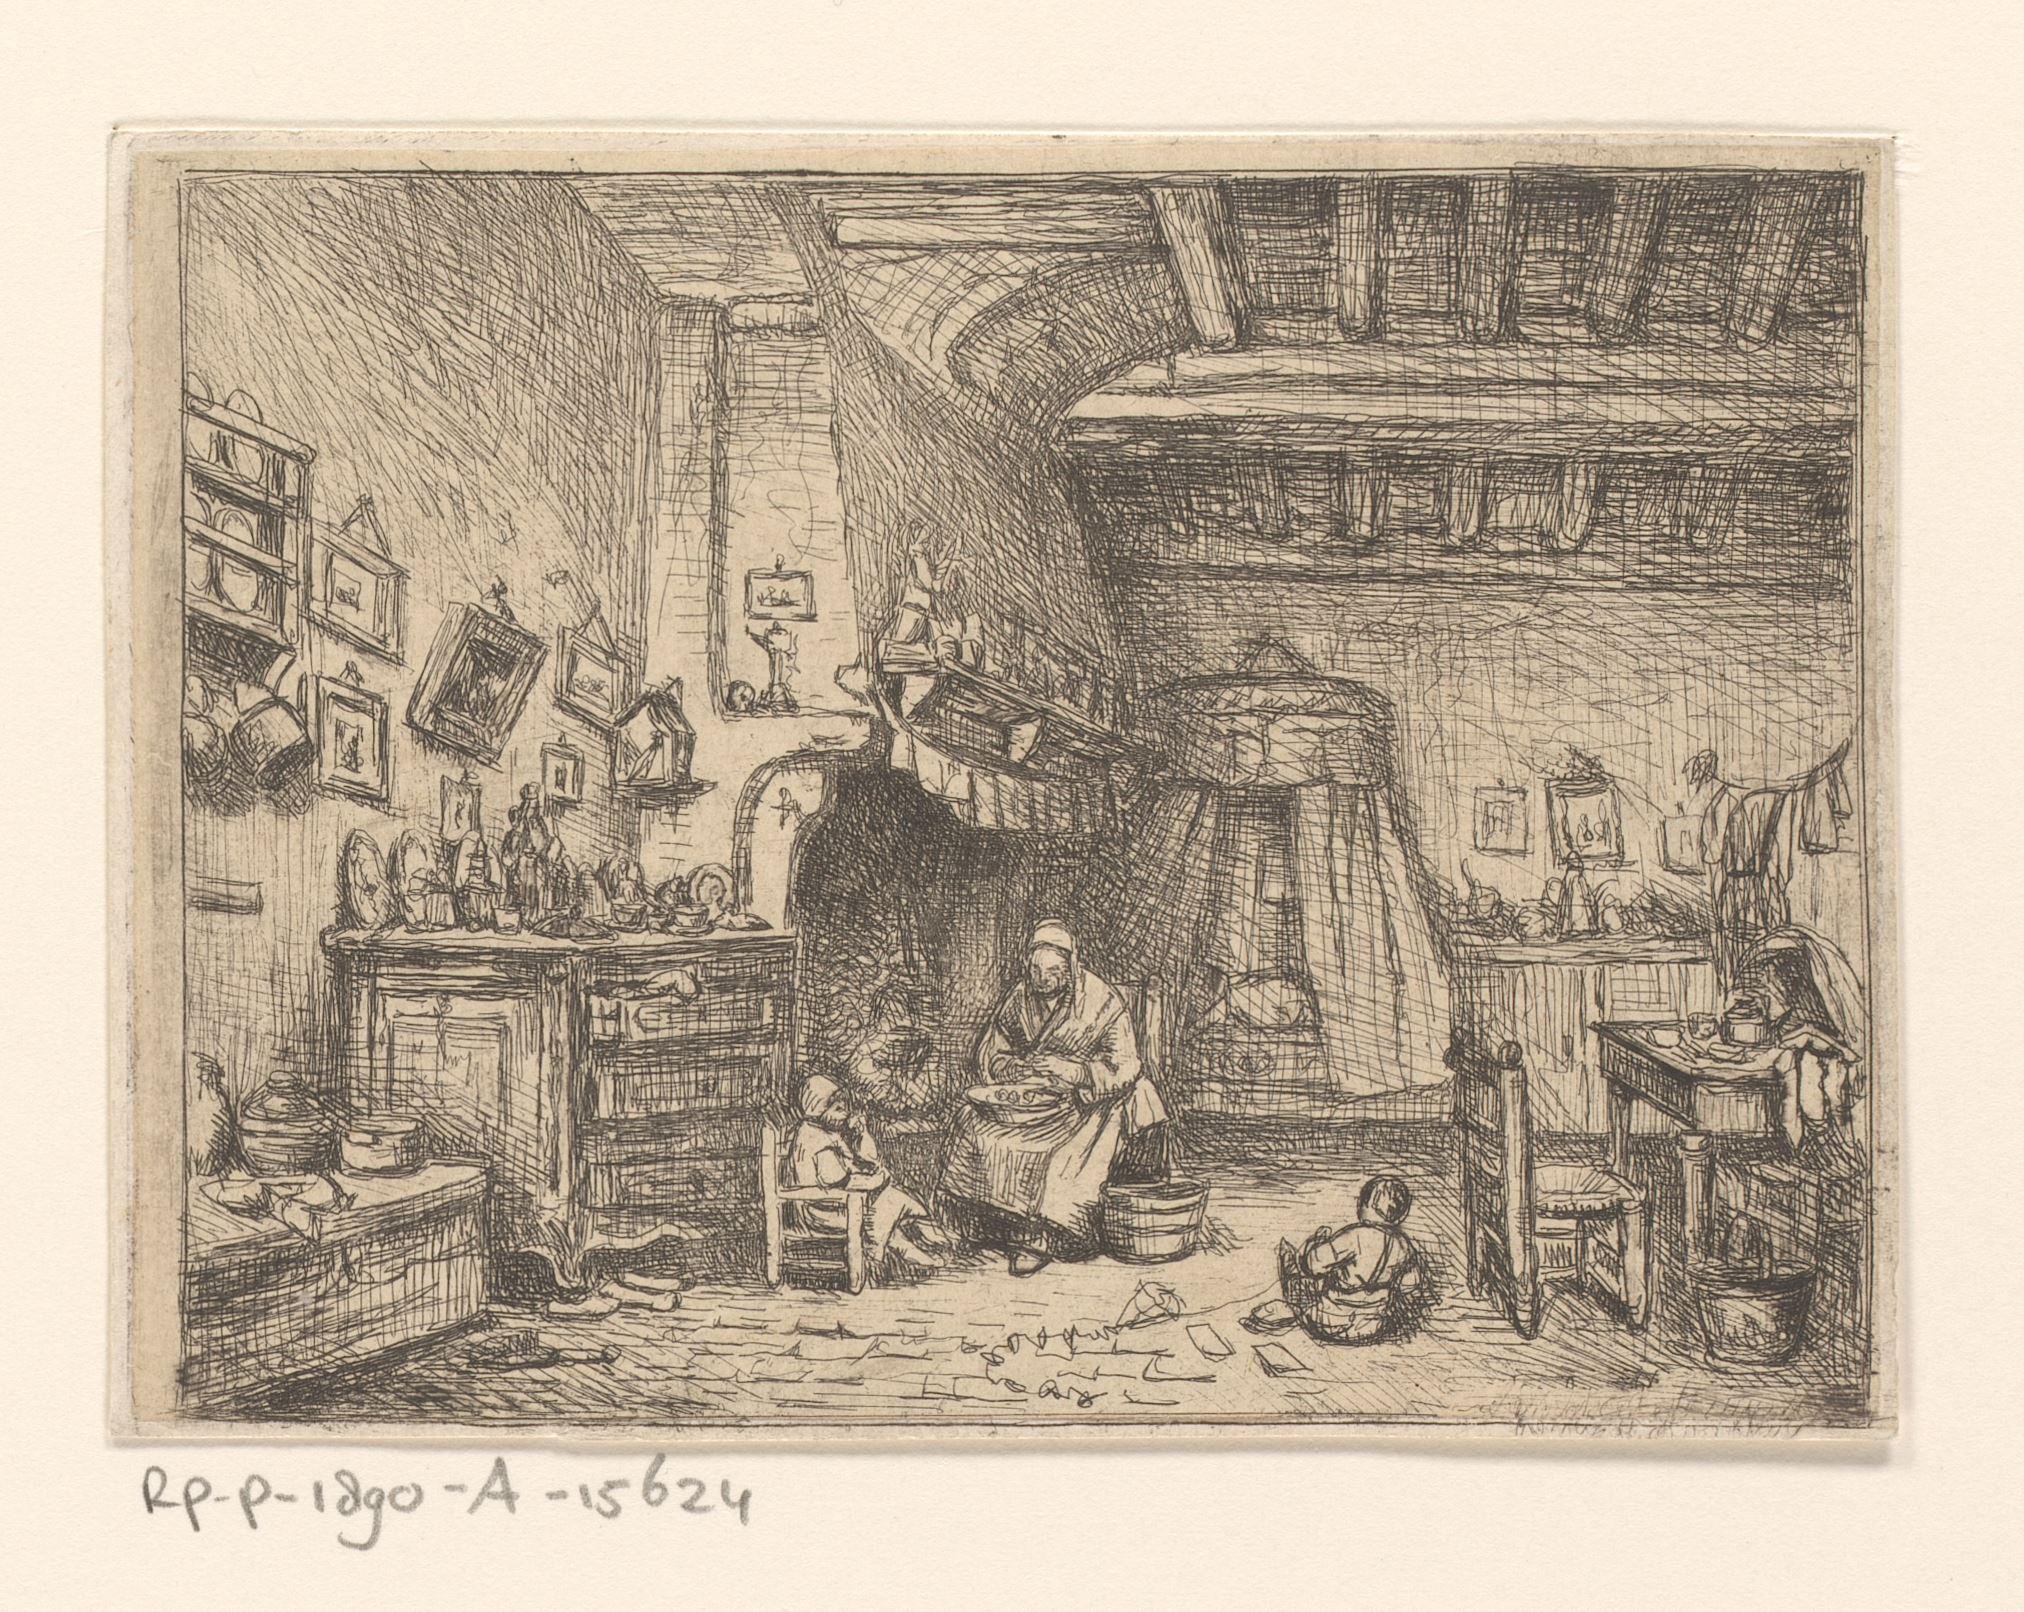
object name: print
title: Interieur met een vrouw en twee kinderen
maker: henri de braekeleer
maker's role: draughtsman, print maker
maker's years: 1840-1888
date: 1860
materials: paper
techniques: etching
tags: adult woman, mother and baby or young child, (flying a) kite, interior ~ representation of a building, child (at home)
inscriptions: collector's mark: Lugt 2228